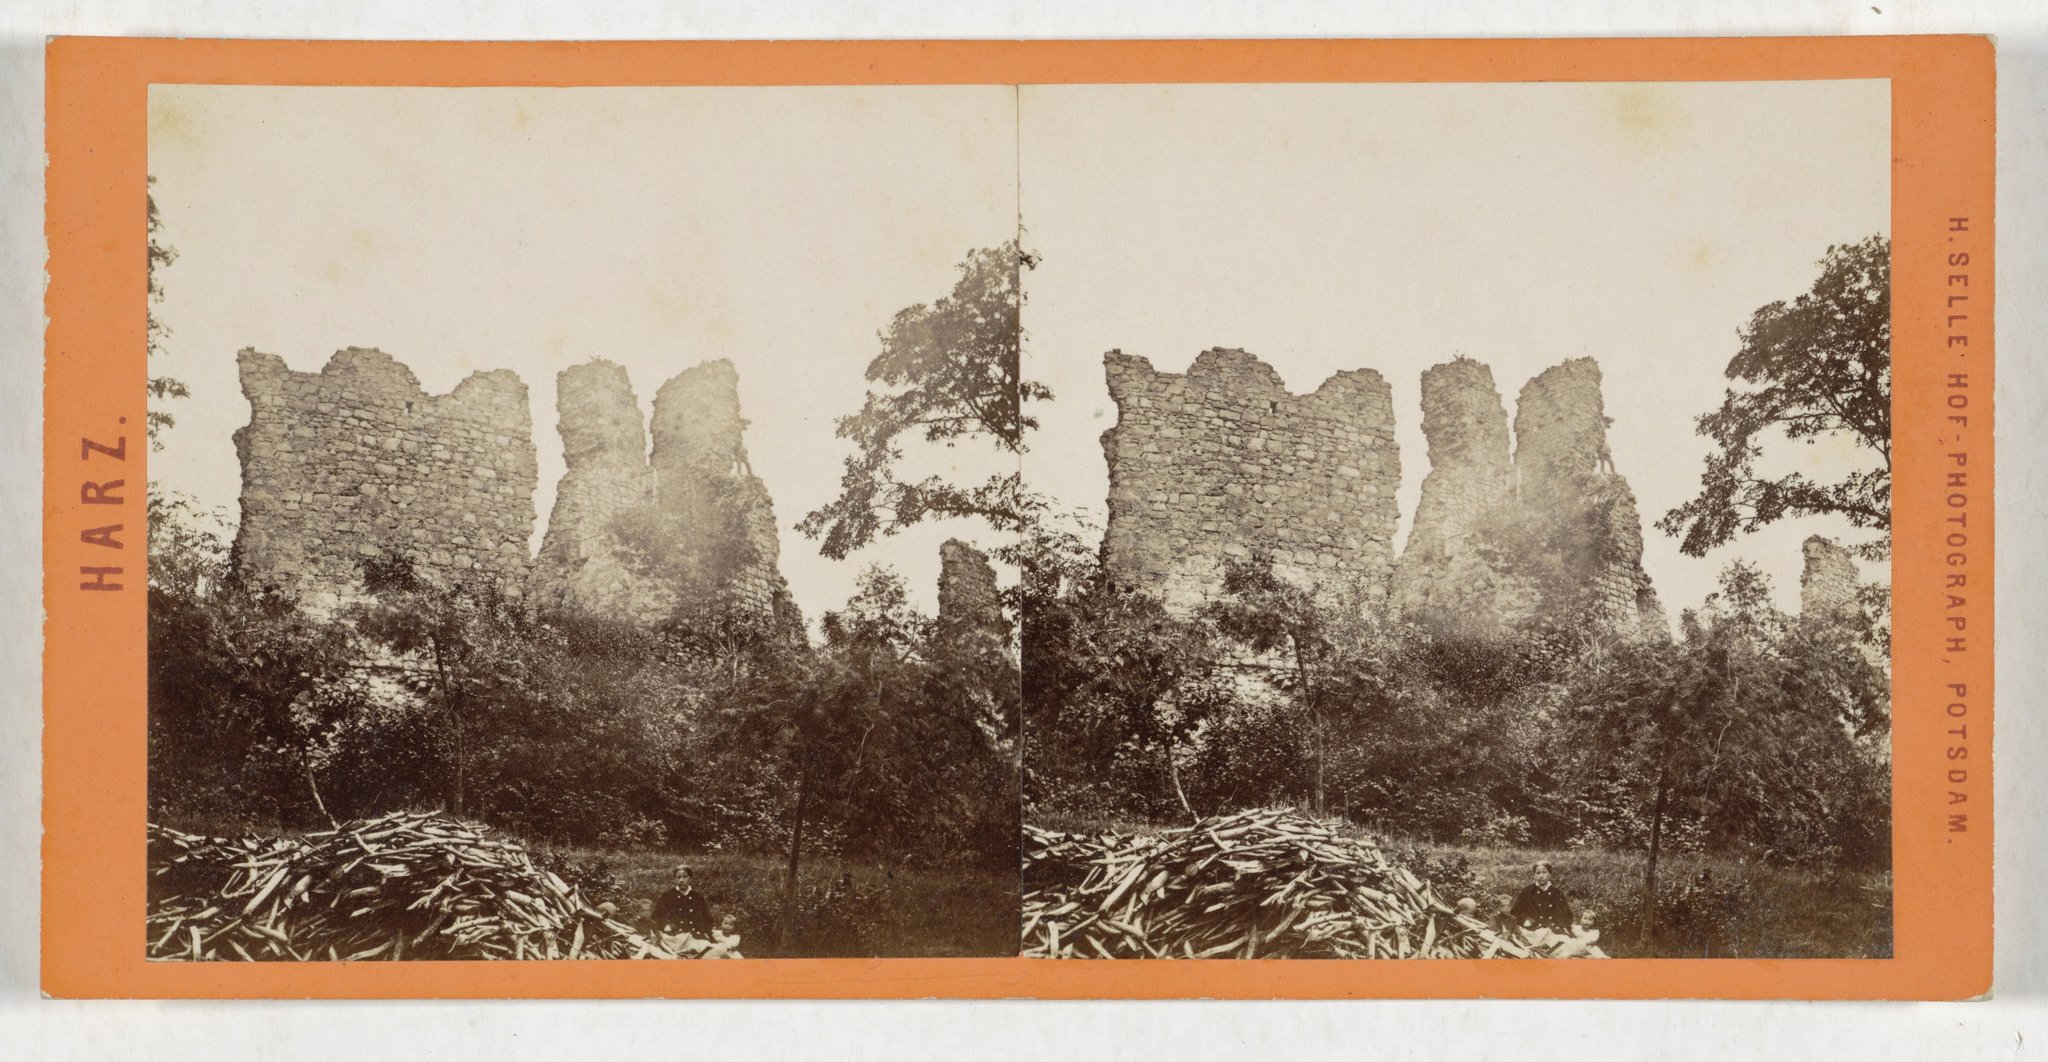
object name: stereograph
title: Die Ruine der Lauenburg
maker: hermann selle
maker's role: fotograaf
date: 1866-1870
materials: cardboard, paper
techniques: albumen print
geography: harz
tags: ruin of a building ~ architecture, ruin of a dwelling, house, castle, etc.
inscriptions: inscription: ‘Hof-Photograph. Potsdam.’, inscription: ‘Zu den schönsten Pünkten des Unterharzes (...) "die Blume der Lauenburg". (W. Riehl.)’, number: ‘No. 13.’